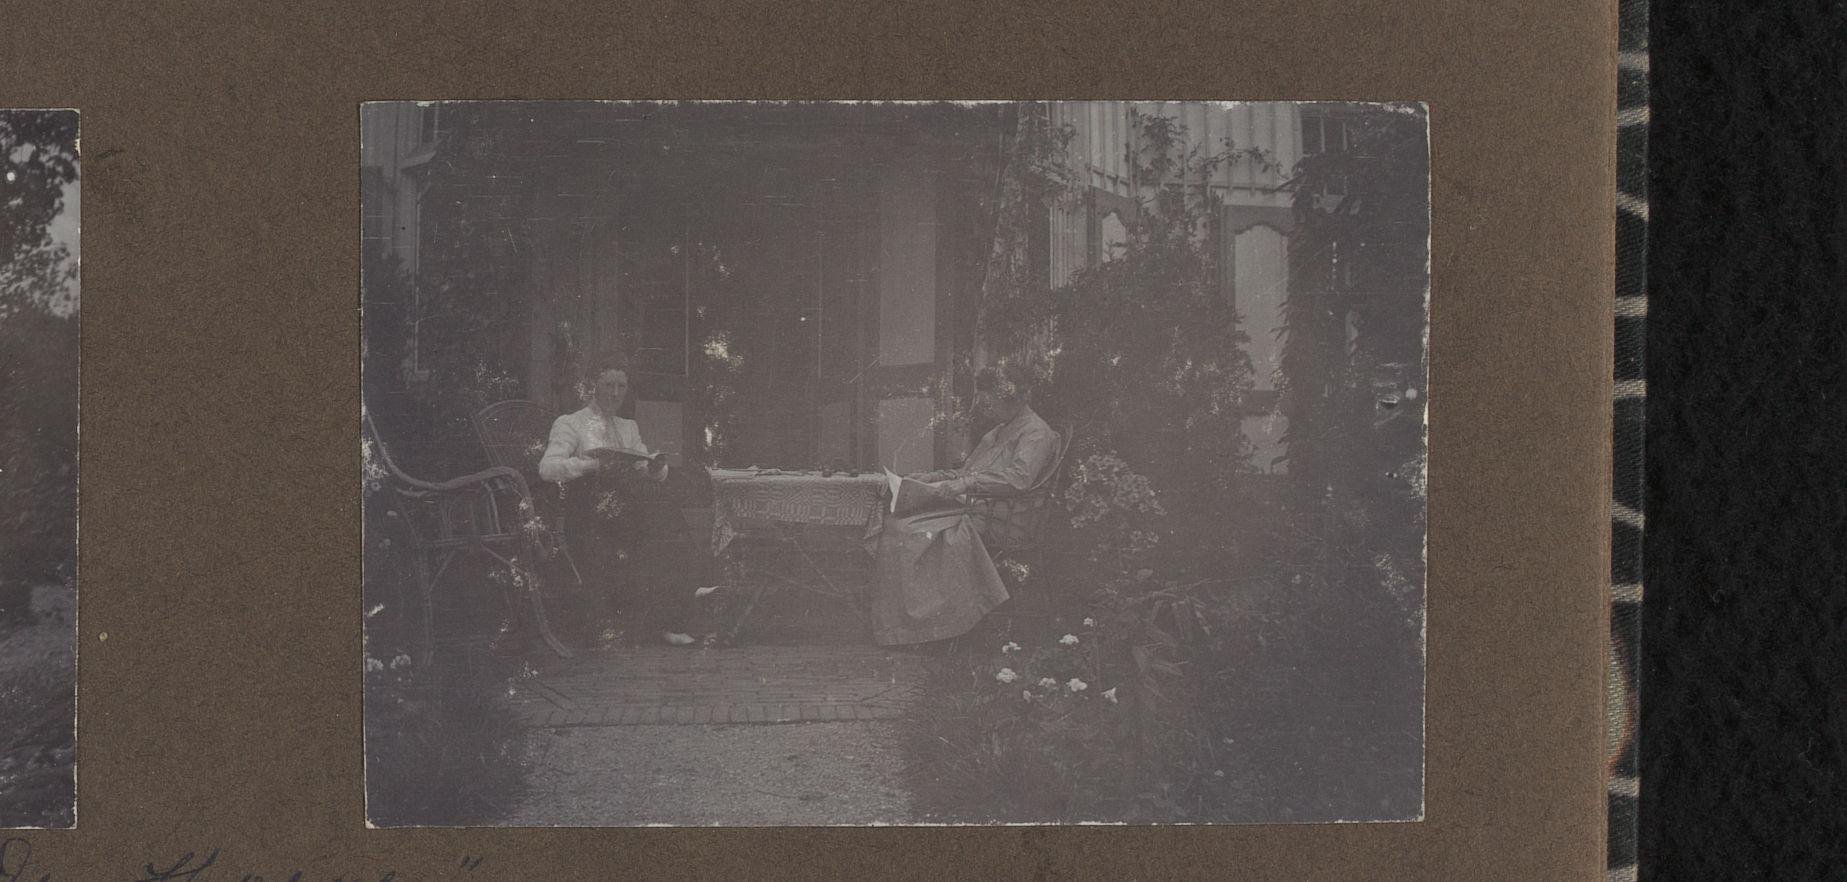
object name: photograph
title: Twee vrouwen aan tafel op het terras van villa De Hoeve in Laren, waaronder mogelijk Saar de Swart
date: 1895-1925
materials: paper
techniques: collodion silver print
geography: laren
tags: arnhem, sculptor, saar de swart, historical persons - bb - woman, loggia, verandah, porch, backyard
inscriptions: inscription: ‘"De Hoeve"’